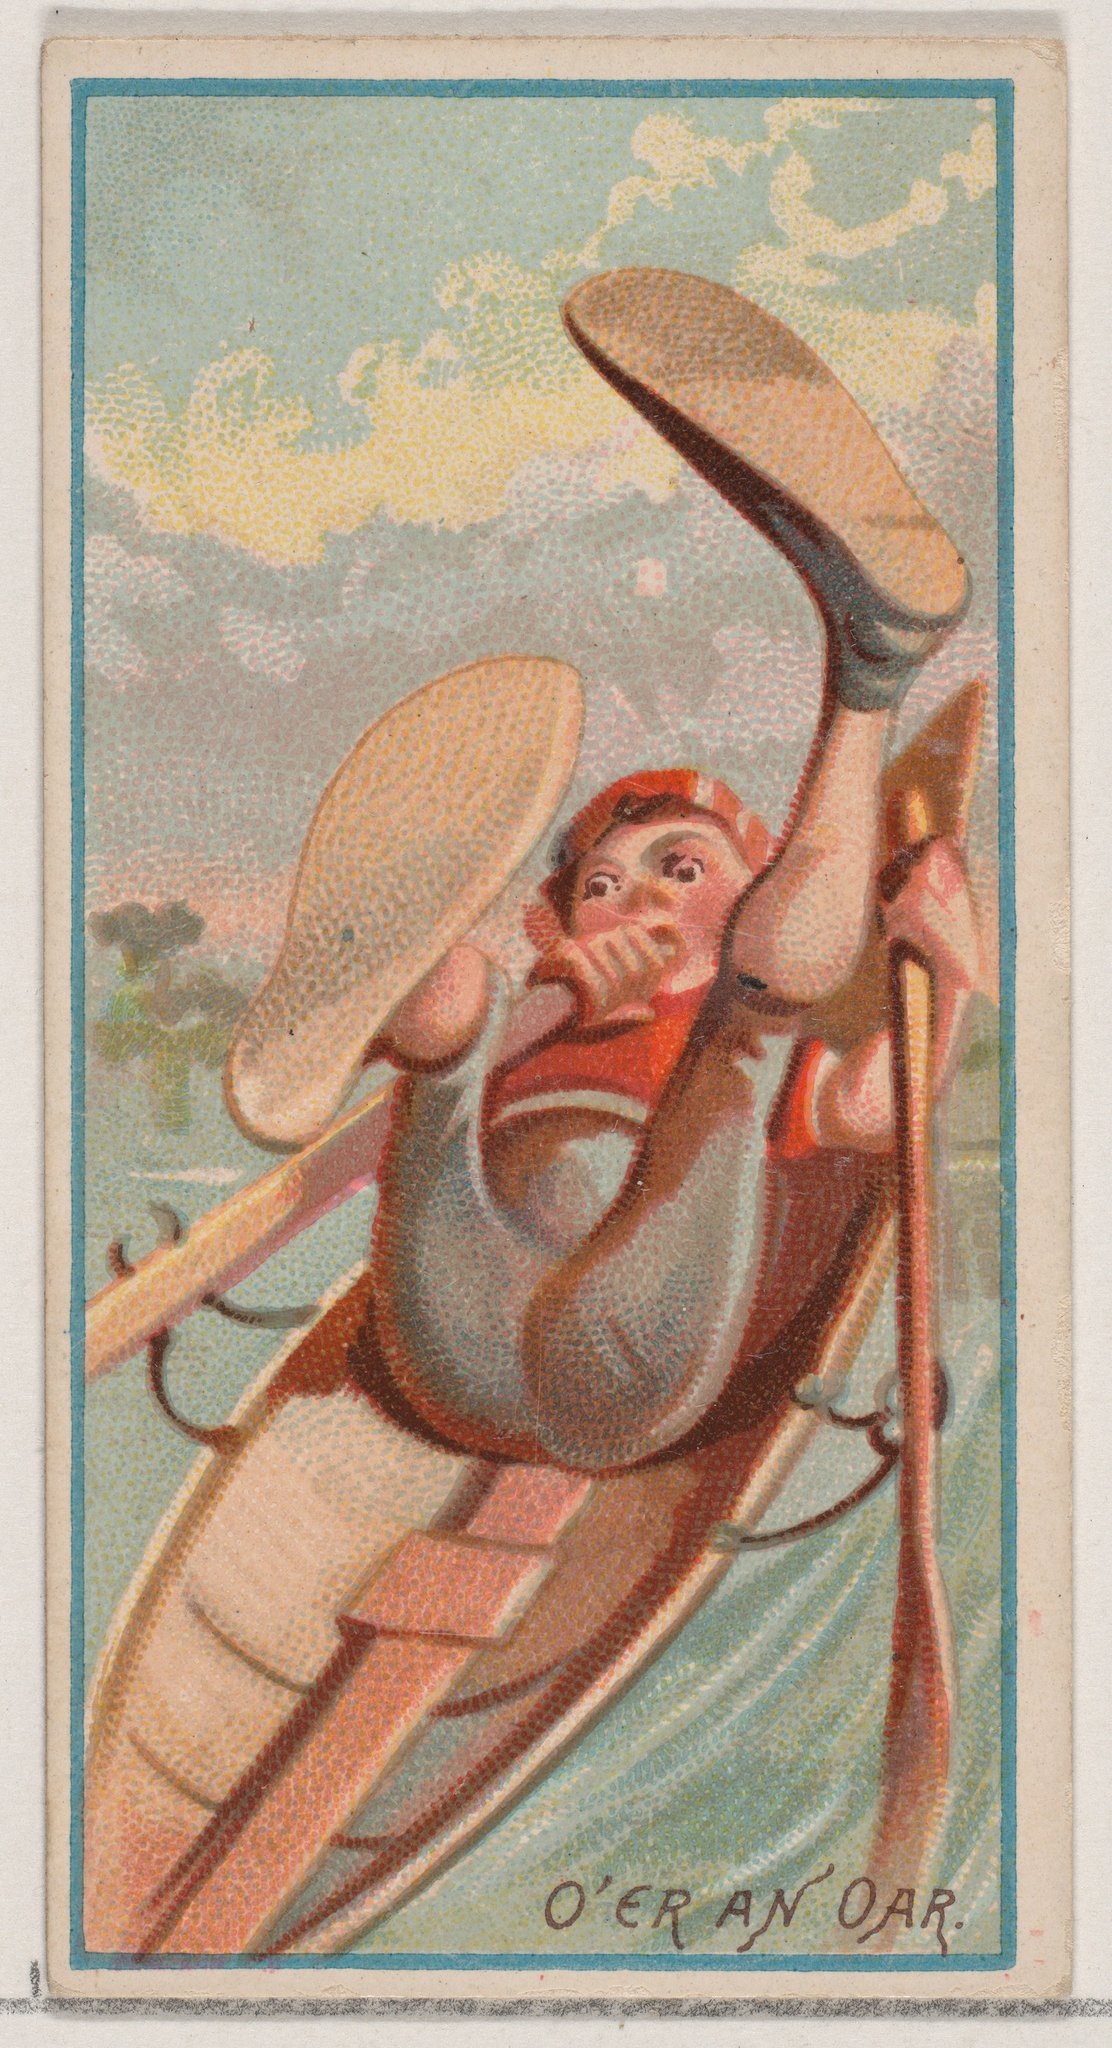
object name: print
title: O'er an Oar, from the Jokes series (N87) for Duke brand cigarettes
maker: w. duke, sons & co.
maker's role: publisher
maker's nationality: american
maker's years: 1870-1920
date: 1890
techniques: color lithograph